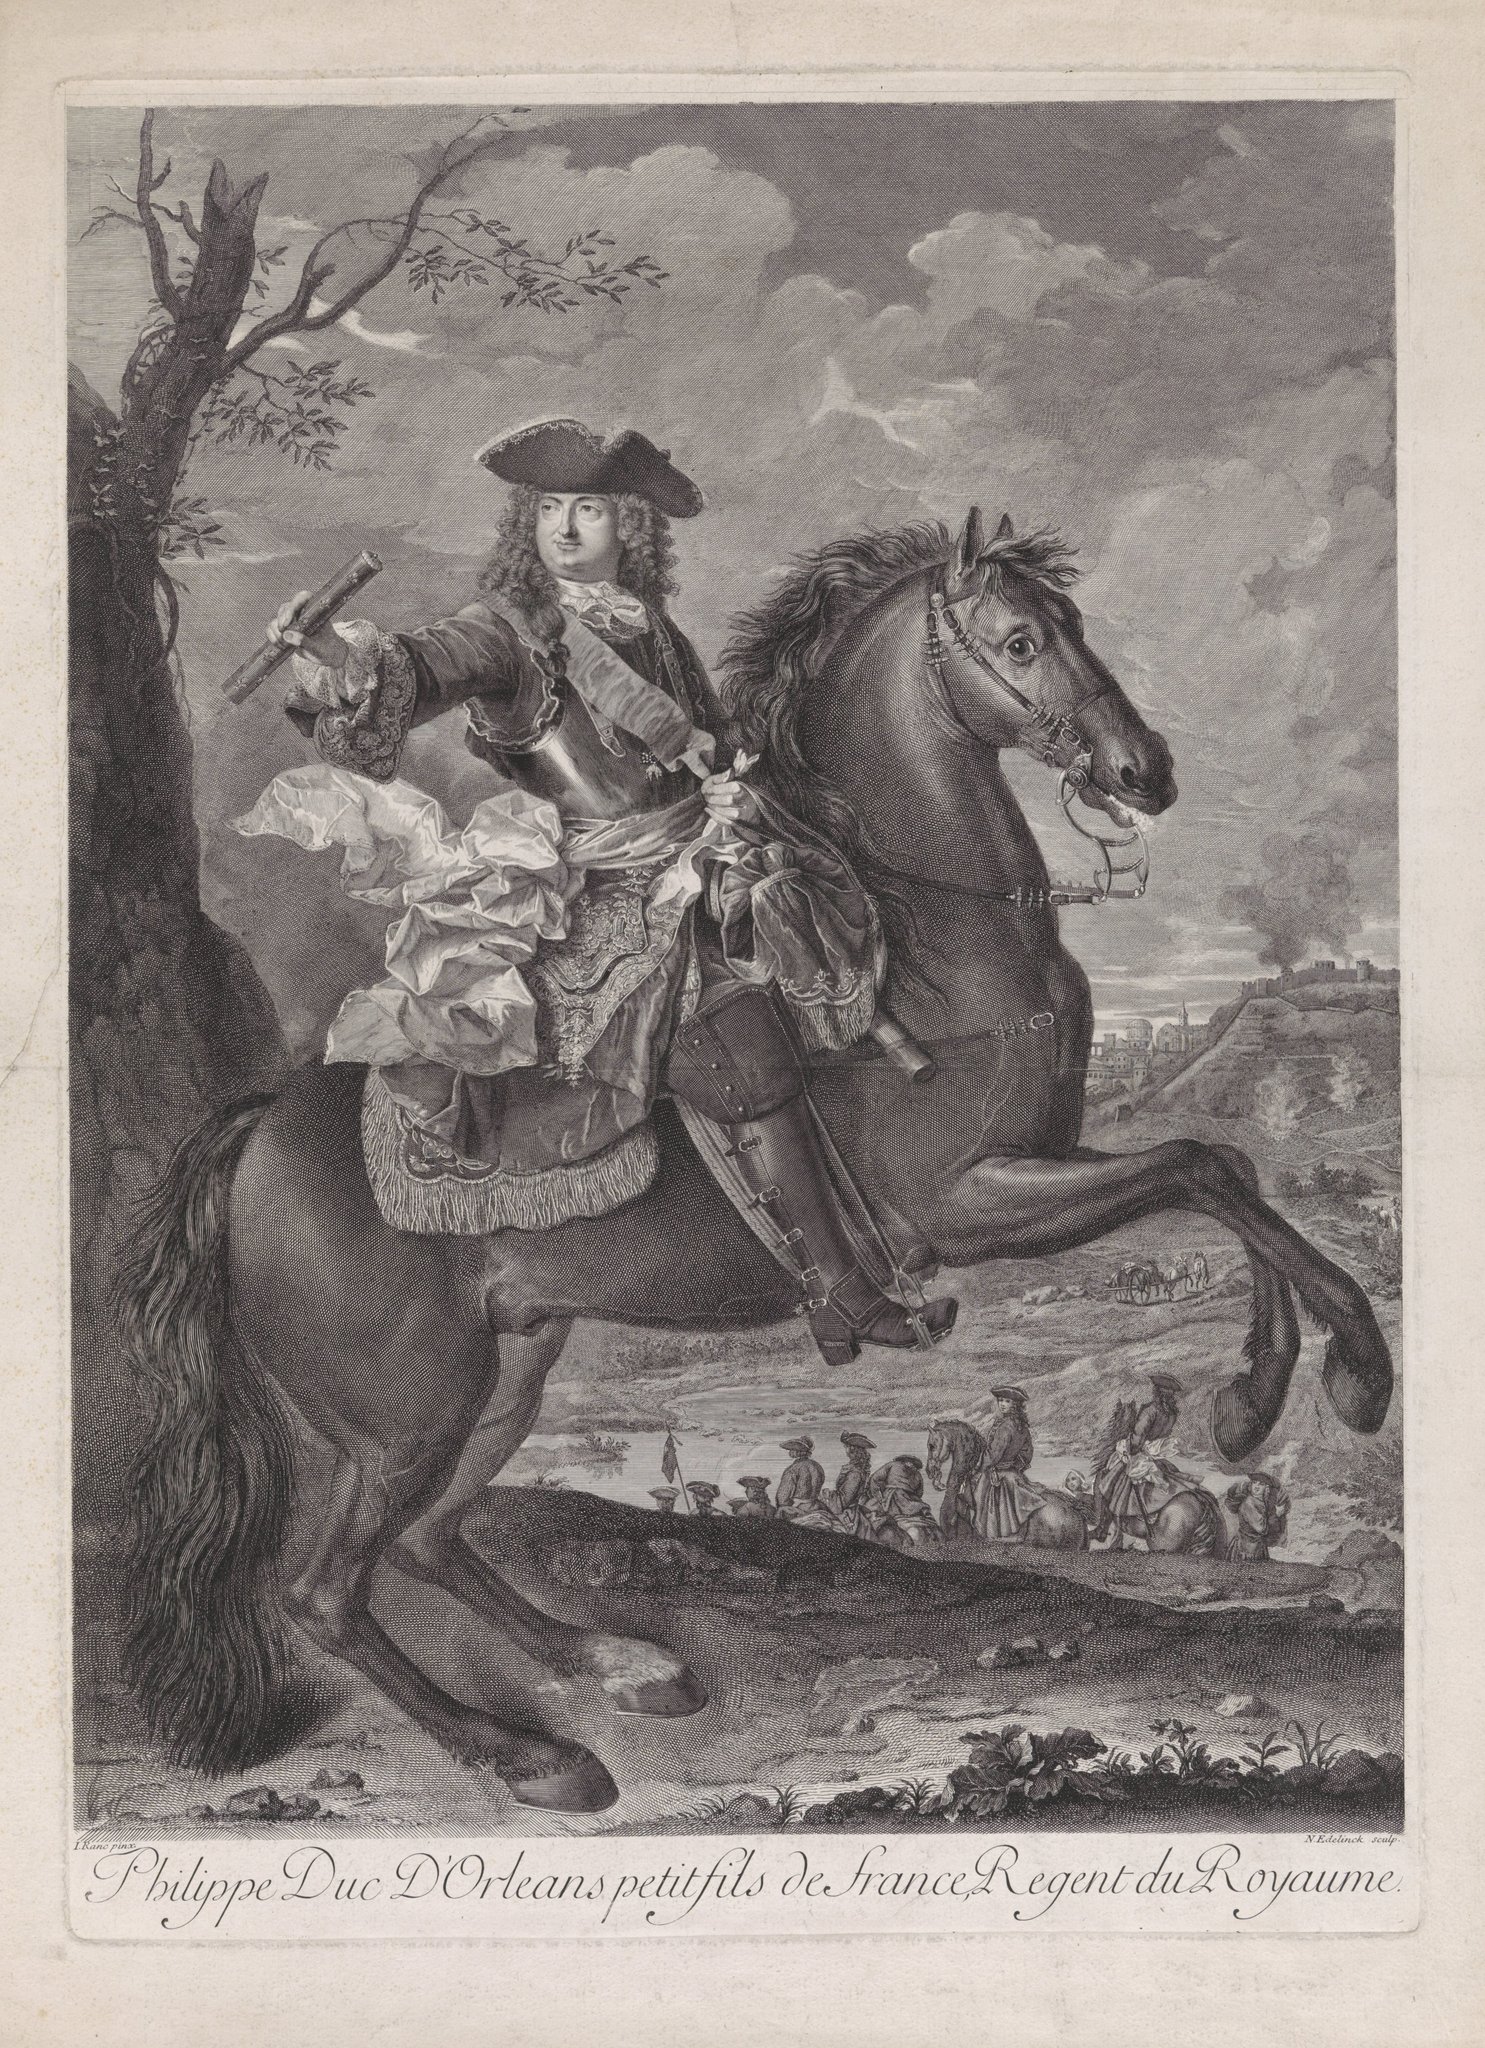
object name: print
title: Ruiterportret van Filips II van Orléans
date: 1691-1767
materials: paper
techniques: engraving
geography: paris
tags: filips ii (hertog van orléans)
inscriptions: collector's mark: Lugt 240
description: Portret van Filips II, hertog van Orléans, met commandostaf in uitgestrekte arm, op een steigerend paard. Op de achtergrond is een colonne cavaleristen op weg naar een belegerd fort bij een stad.